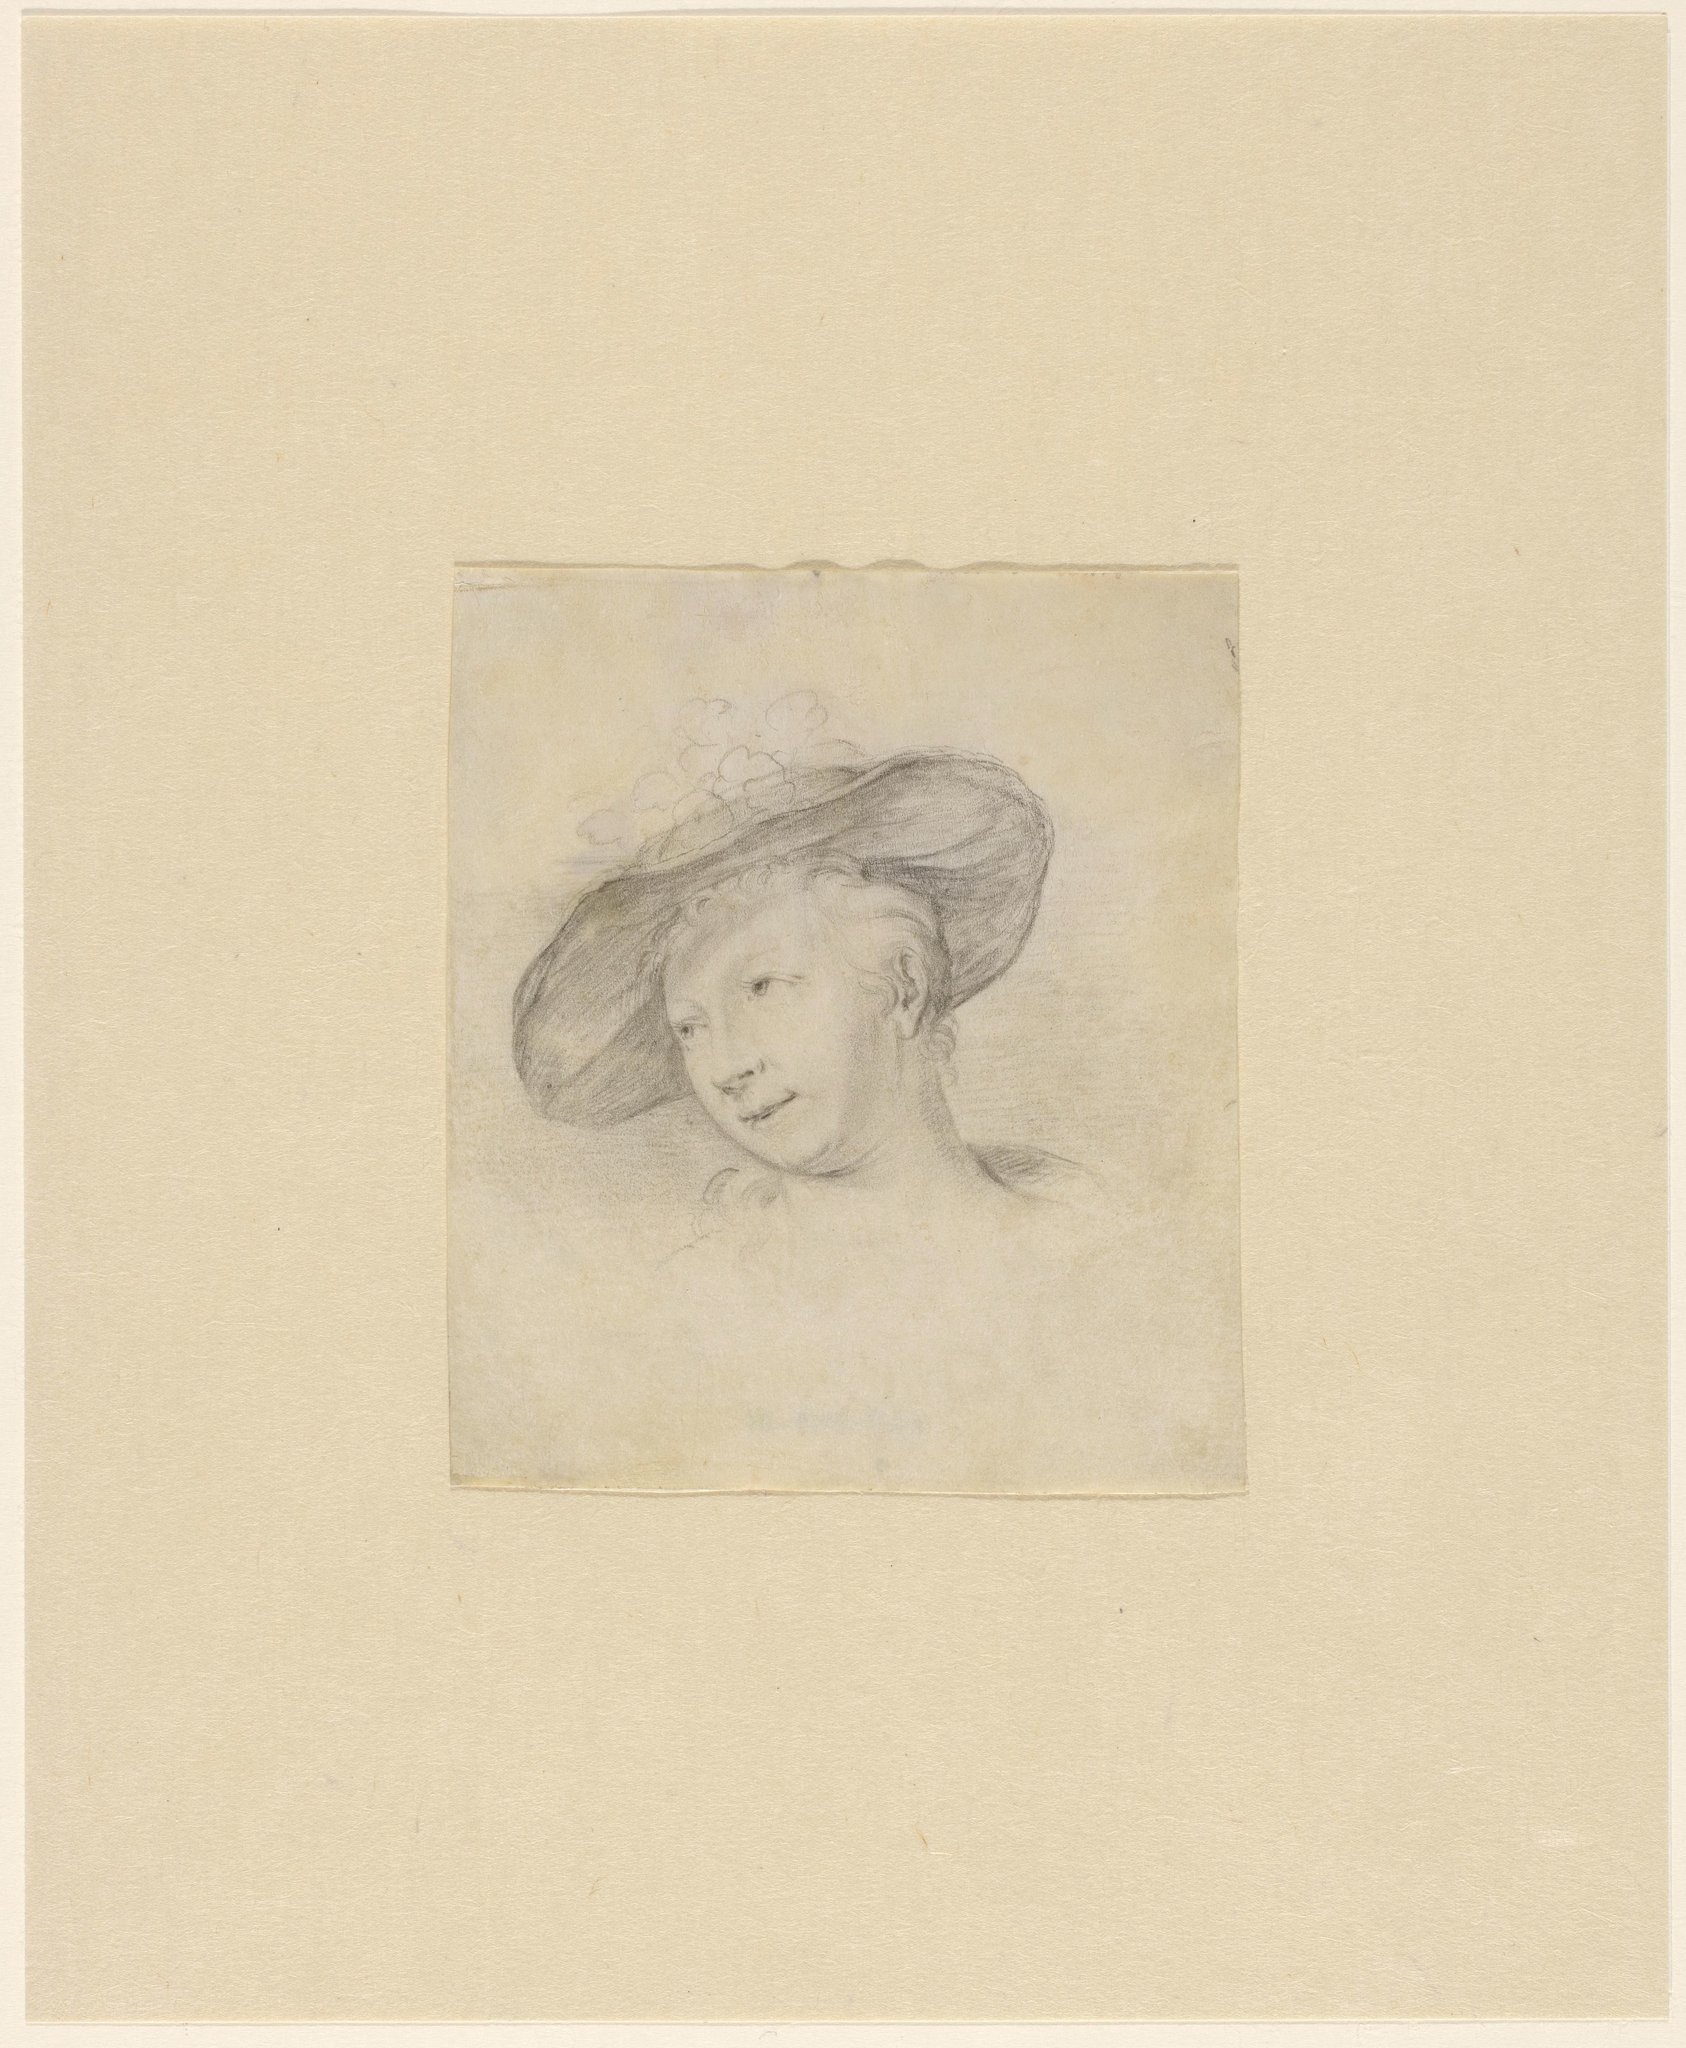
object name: drawing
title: Hoofd van een elegante herderin met hoed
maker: hieronymus van der mij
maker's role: painter, print maker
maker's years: 1687-1761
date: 1730-1735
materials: chalk, parchment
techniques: drawing